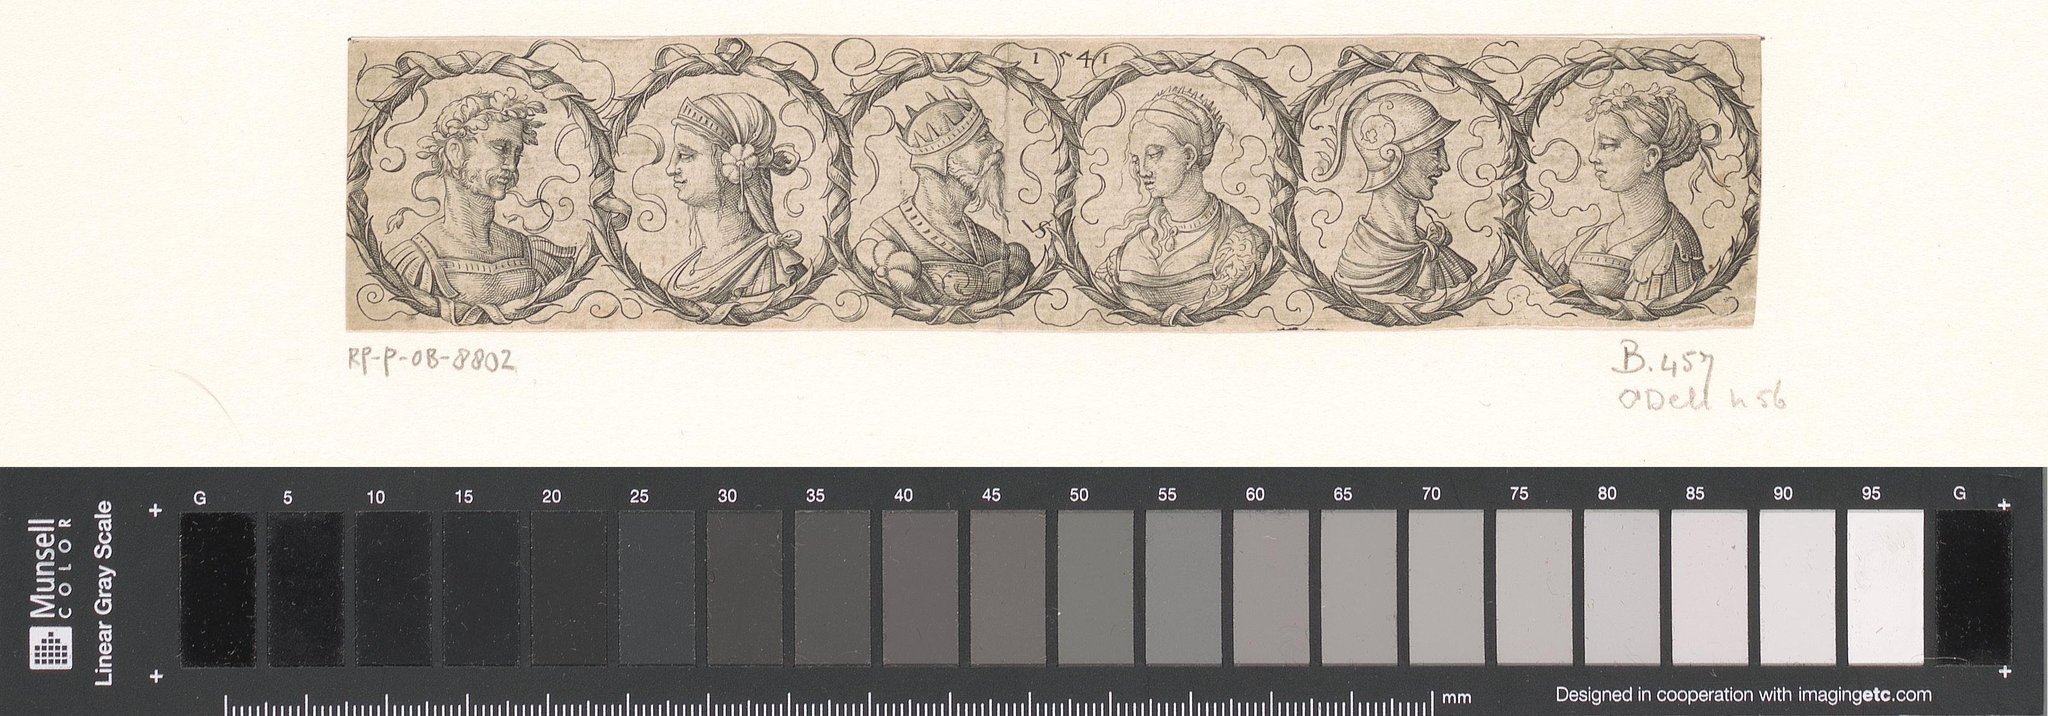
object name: print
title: Fries met zes bustes in lauwerkransen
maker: virgilius solis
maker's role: draughtsman, print maker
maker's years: 1514-1562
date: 1541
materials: paper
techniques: engraving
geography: nuremberg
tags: helmet, chest, bust, head-gear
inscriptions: number: ‘20,1. - 55.’, collector's mark: Lugt 2228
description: Bustes van drie mannen en drie vrouwen, en profil en per twee naar elkaar gericht.